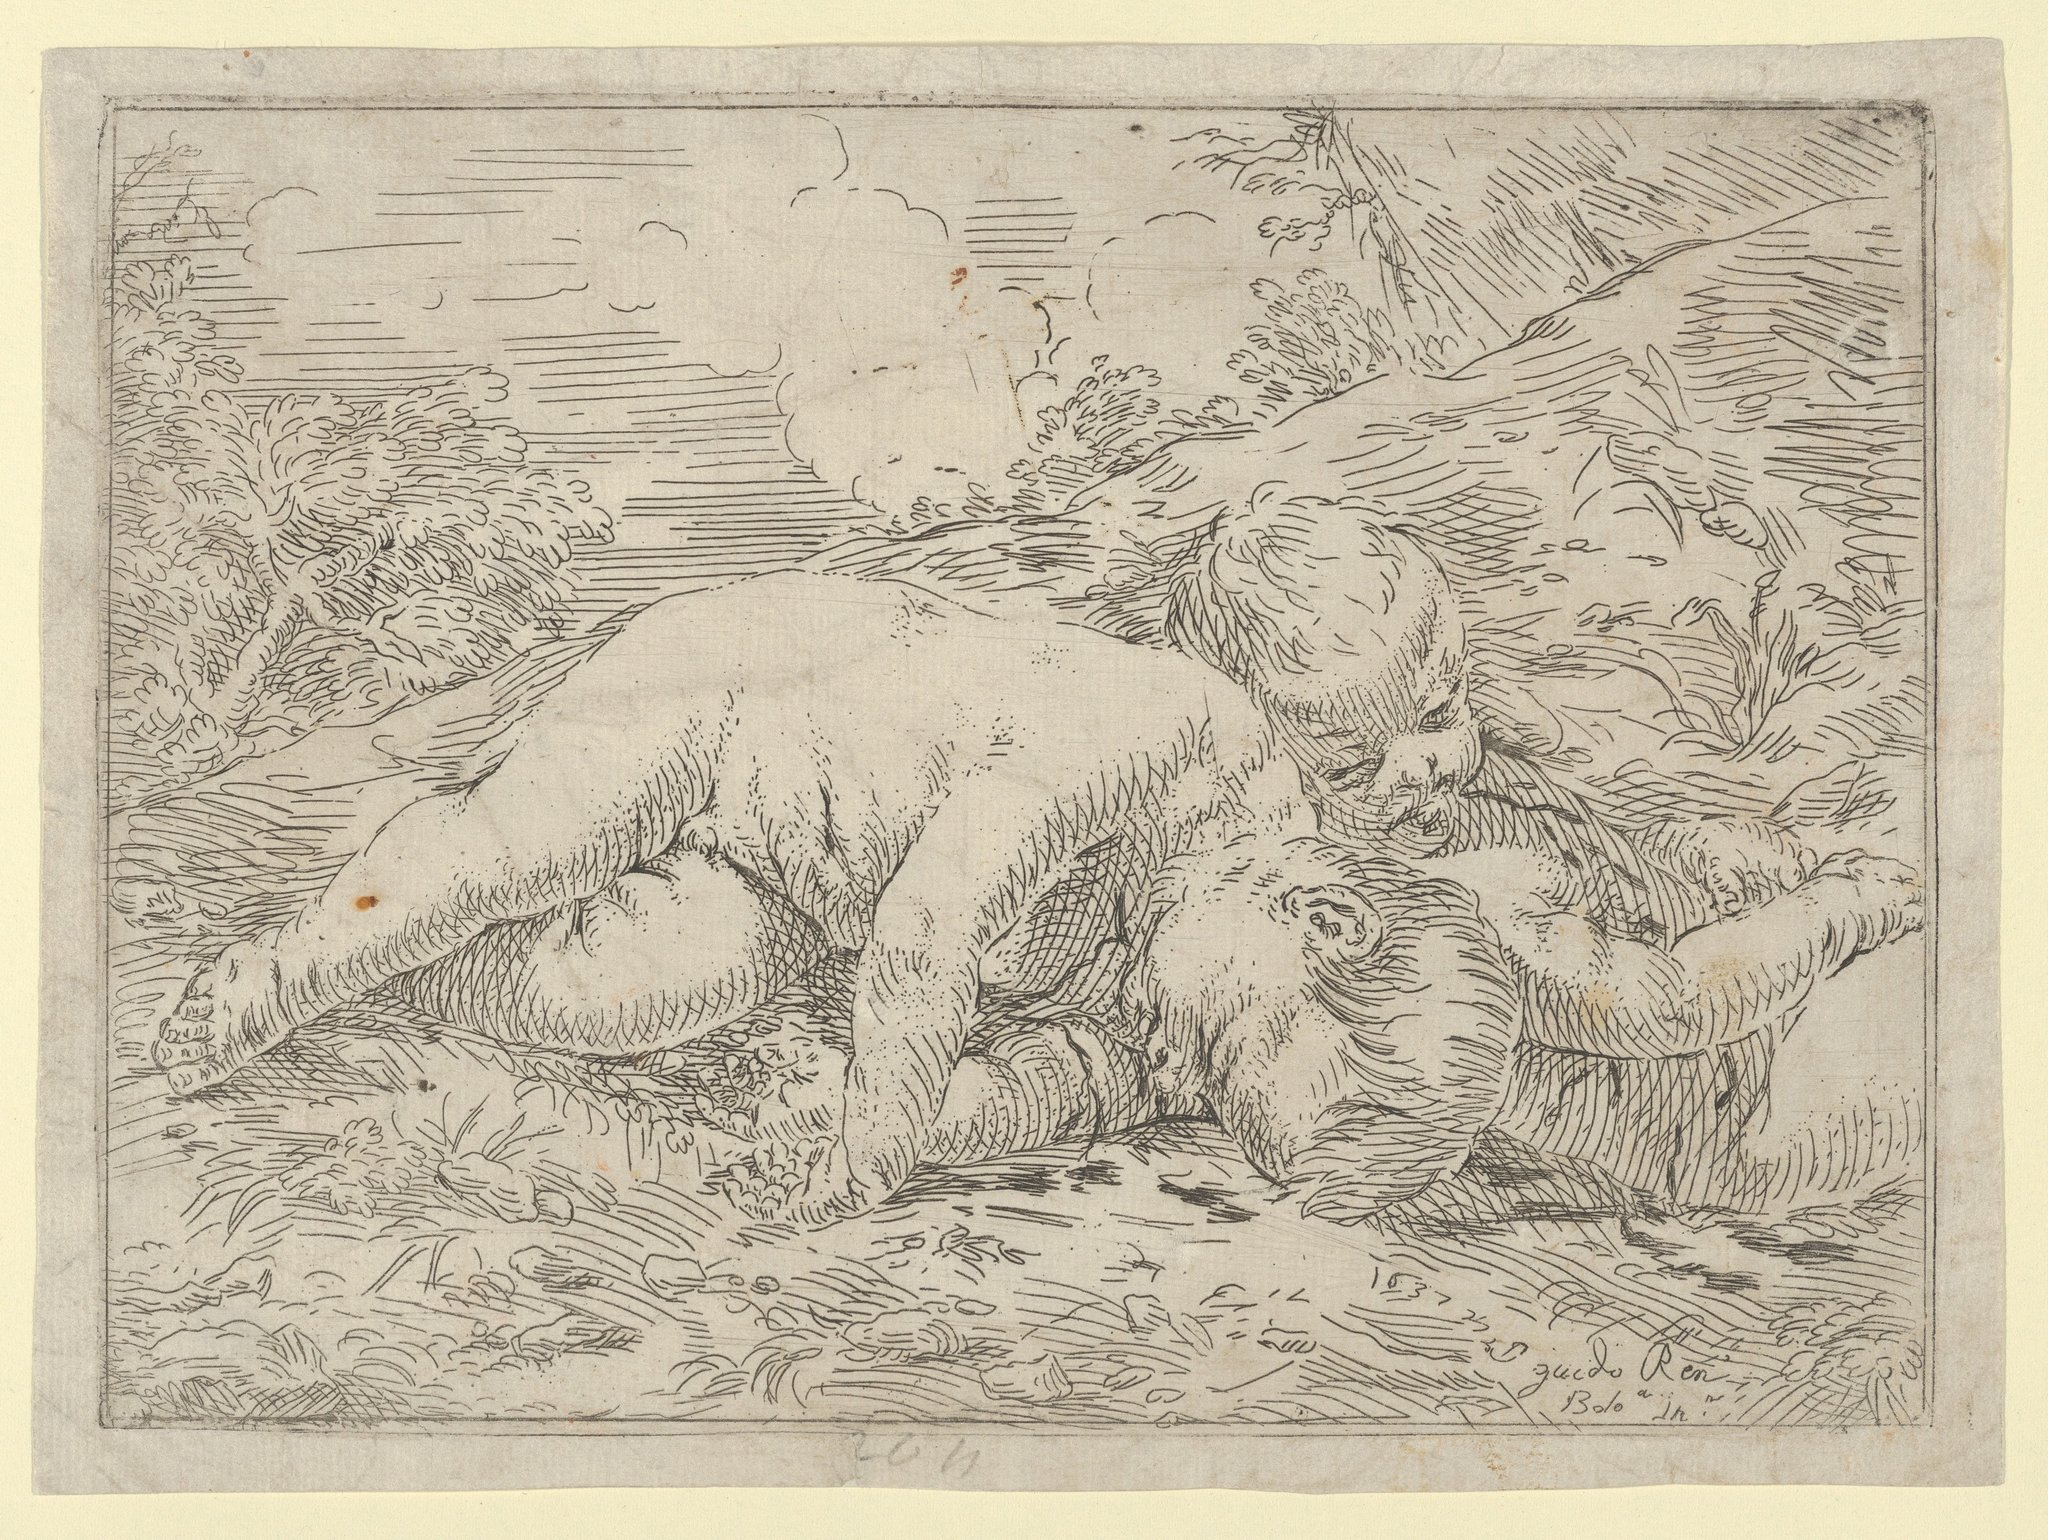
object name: print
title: Two putti sleeping in a landscape, after Reni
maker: anonymous, italian, 17th century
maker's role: artist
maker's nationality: italian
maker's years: 1600-1700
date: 1637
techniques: etching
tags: sleeping,putti